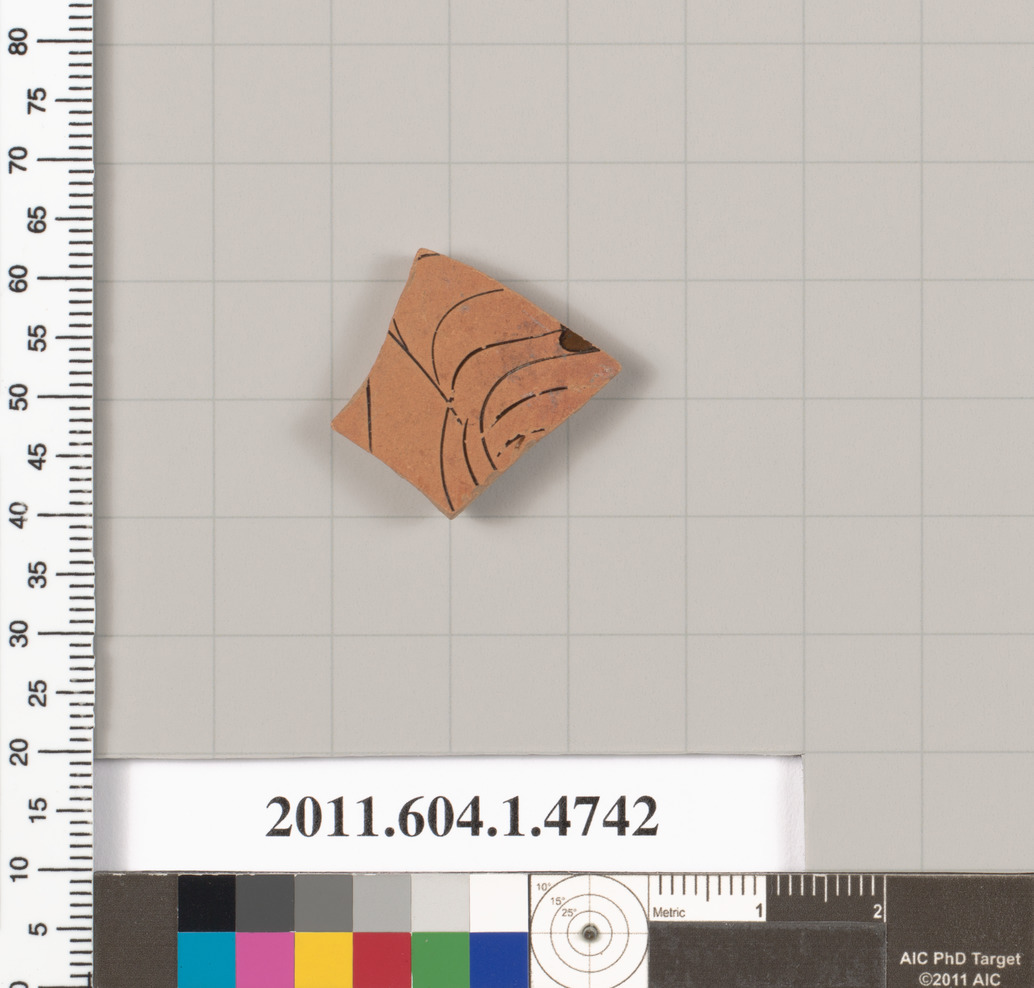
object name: kylix fragment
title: Terracotta fragment of a kylix (drinking cup)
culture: greek, attic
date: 475-451 BCE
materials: terracotta